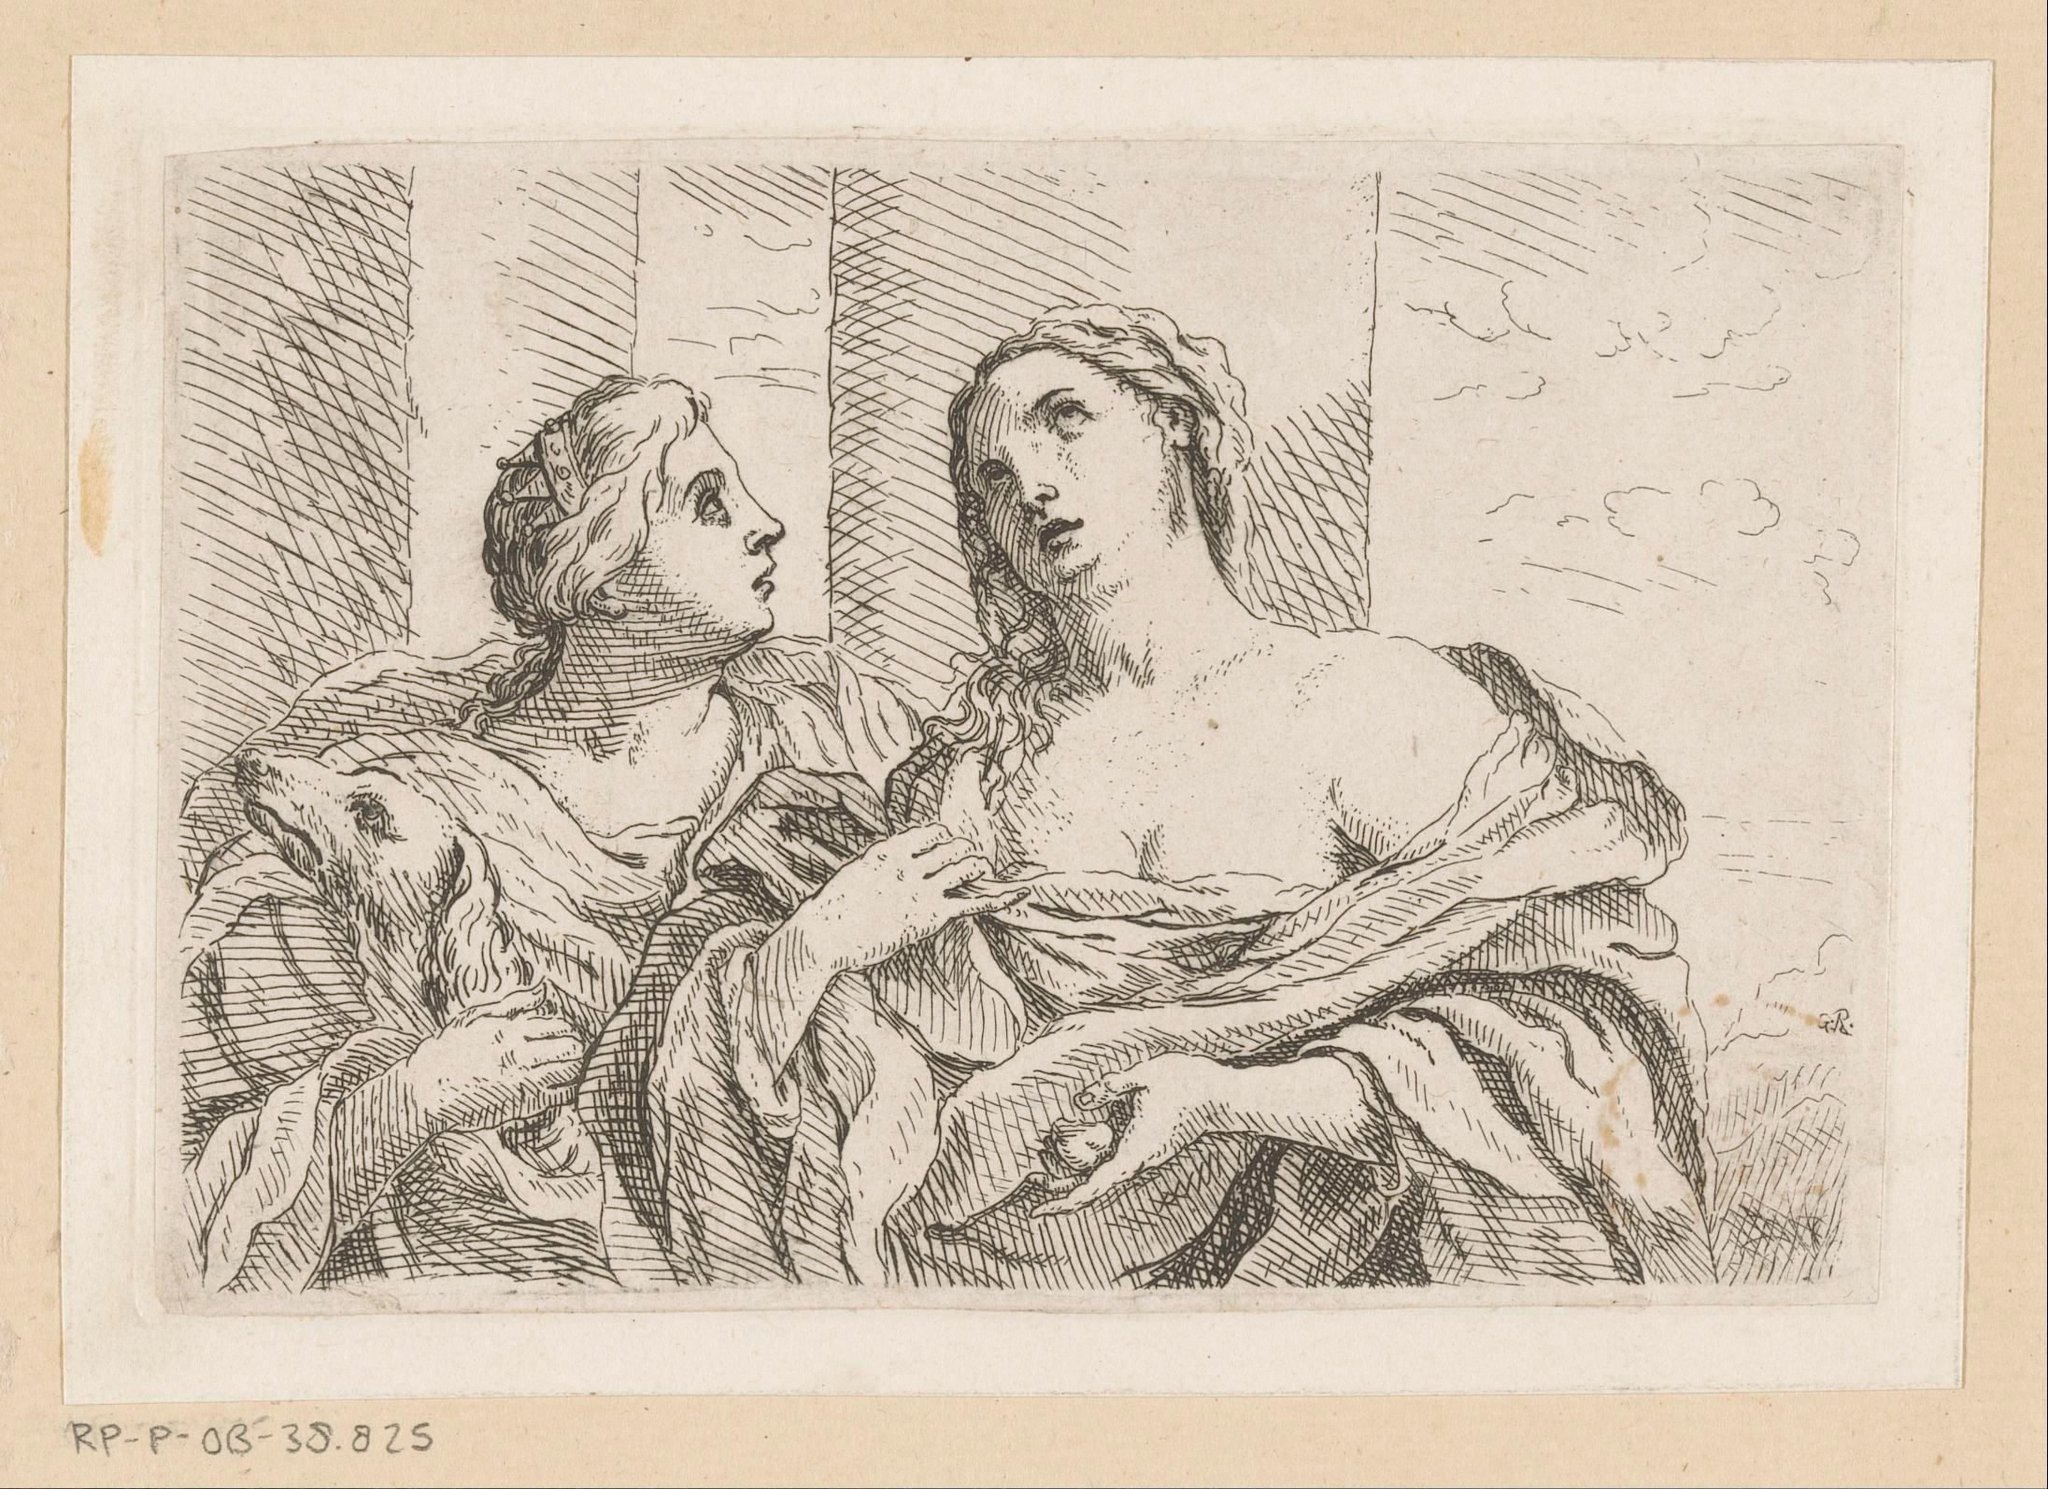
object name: print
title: Twee vrouwen met een hond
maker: Anonymous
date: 1600-1649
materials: paper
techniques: etching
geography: italy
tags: dog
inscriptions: collector's mark: Lugt 240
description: Twee vrouwen met een hond. De linker vrouw draagt een kroon.